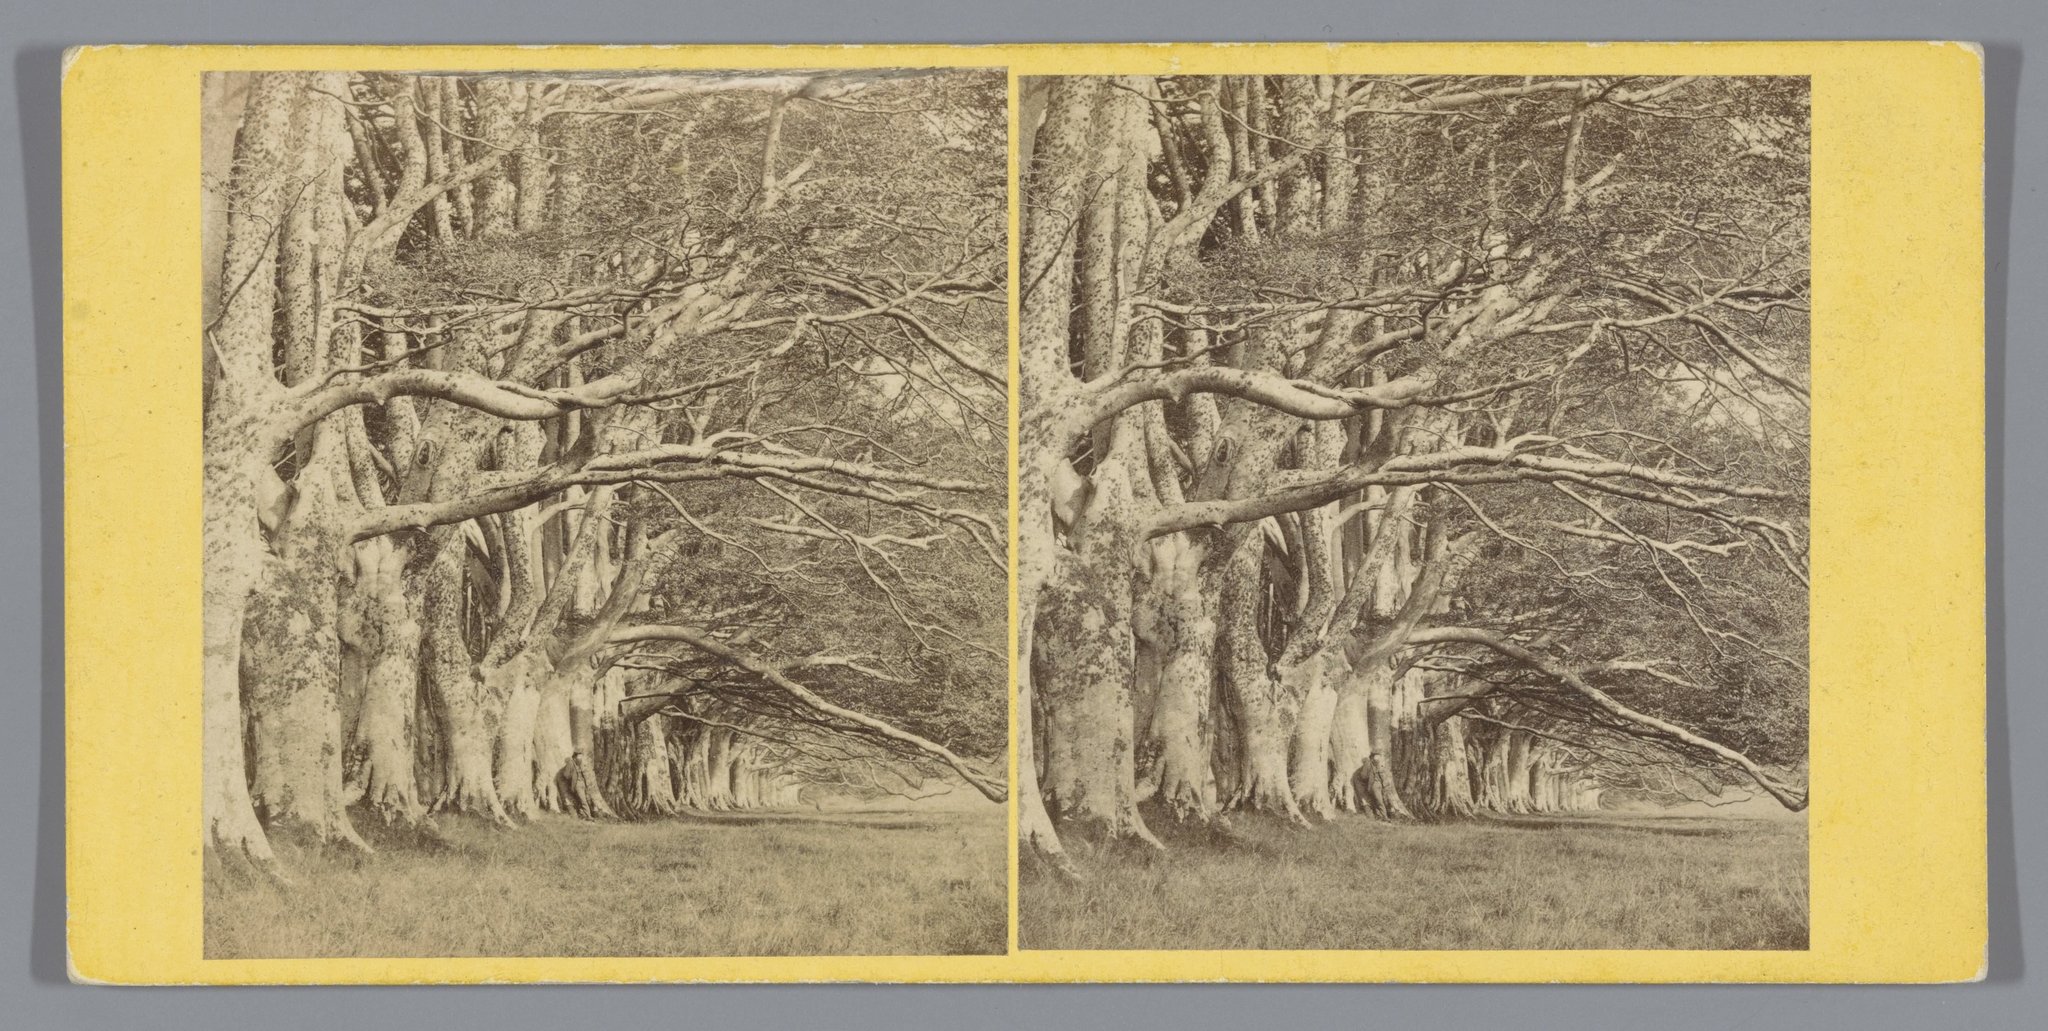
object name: stereograph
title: Bomen langs de Dhu Loch Avenue bij Inveraray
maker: george washington wilson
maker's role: publisher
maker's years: 1823-1893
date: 1850-1880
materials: cardboard, photographic support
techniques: albumen print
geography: inveraray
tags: forest path or lane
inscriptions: number: ‘No. 678 A.’